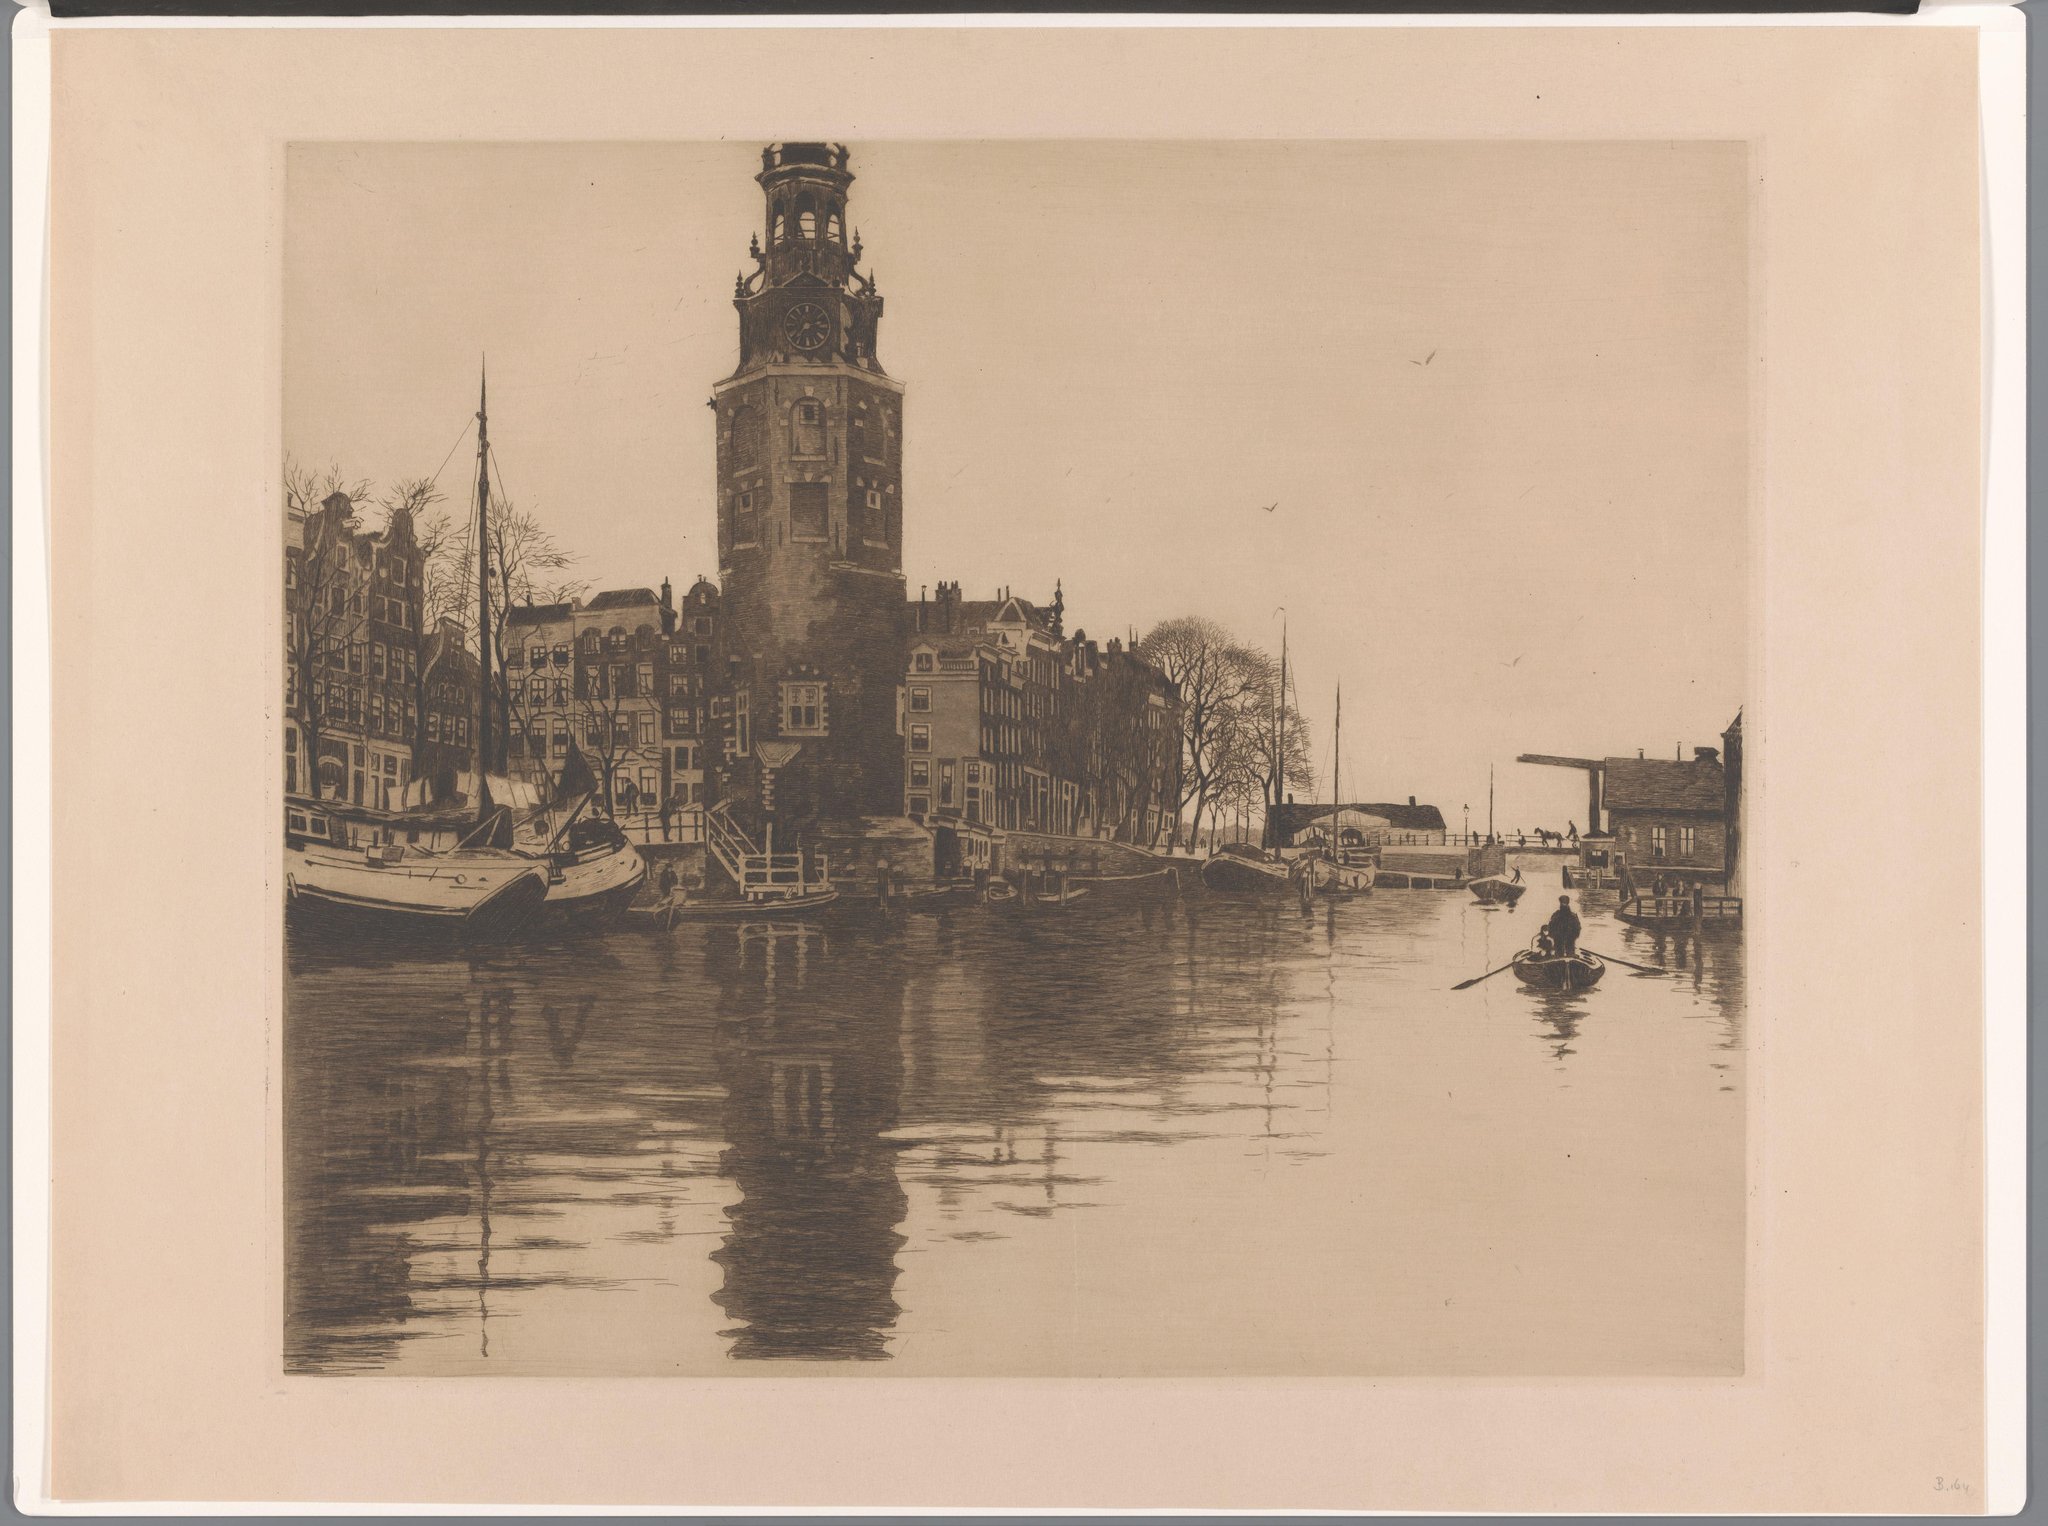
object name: print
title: Oude Schans met Montelbaanstoren en roeiboot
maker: willem witsen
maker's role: draughtsman, painter, print maker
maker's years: 1860-1923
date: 1913-1914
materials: paper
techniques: aquatint, etching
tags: urban housing, towers ~ fortified city, rowing-boat, canoe, etc., bridge in city across river, canal, etc.